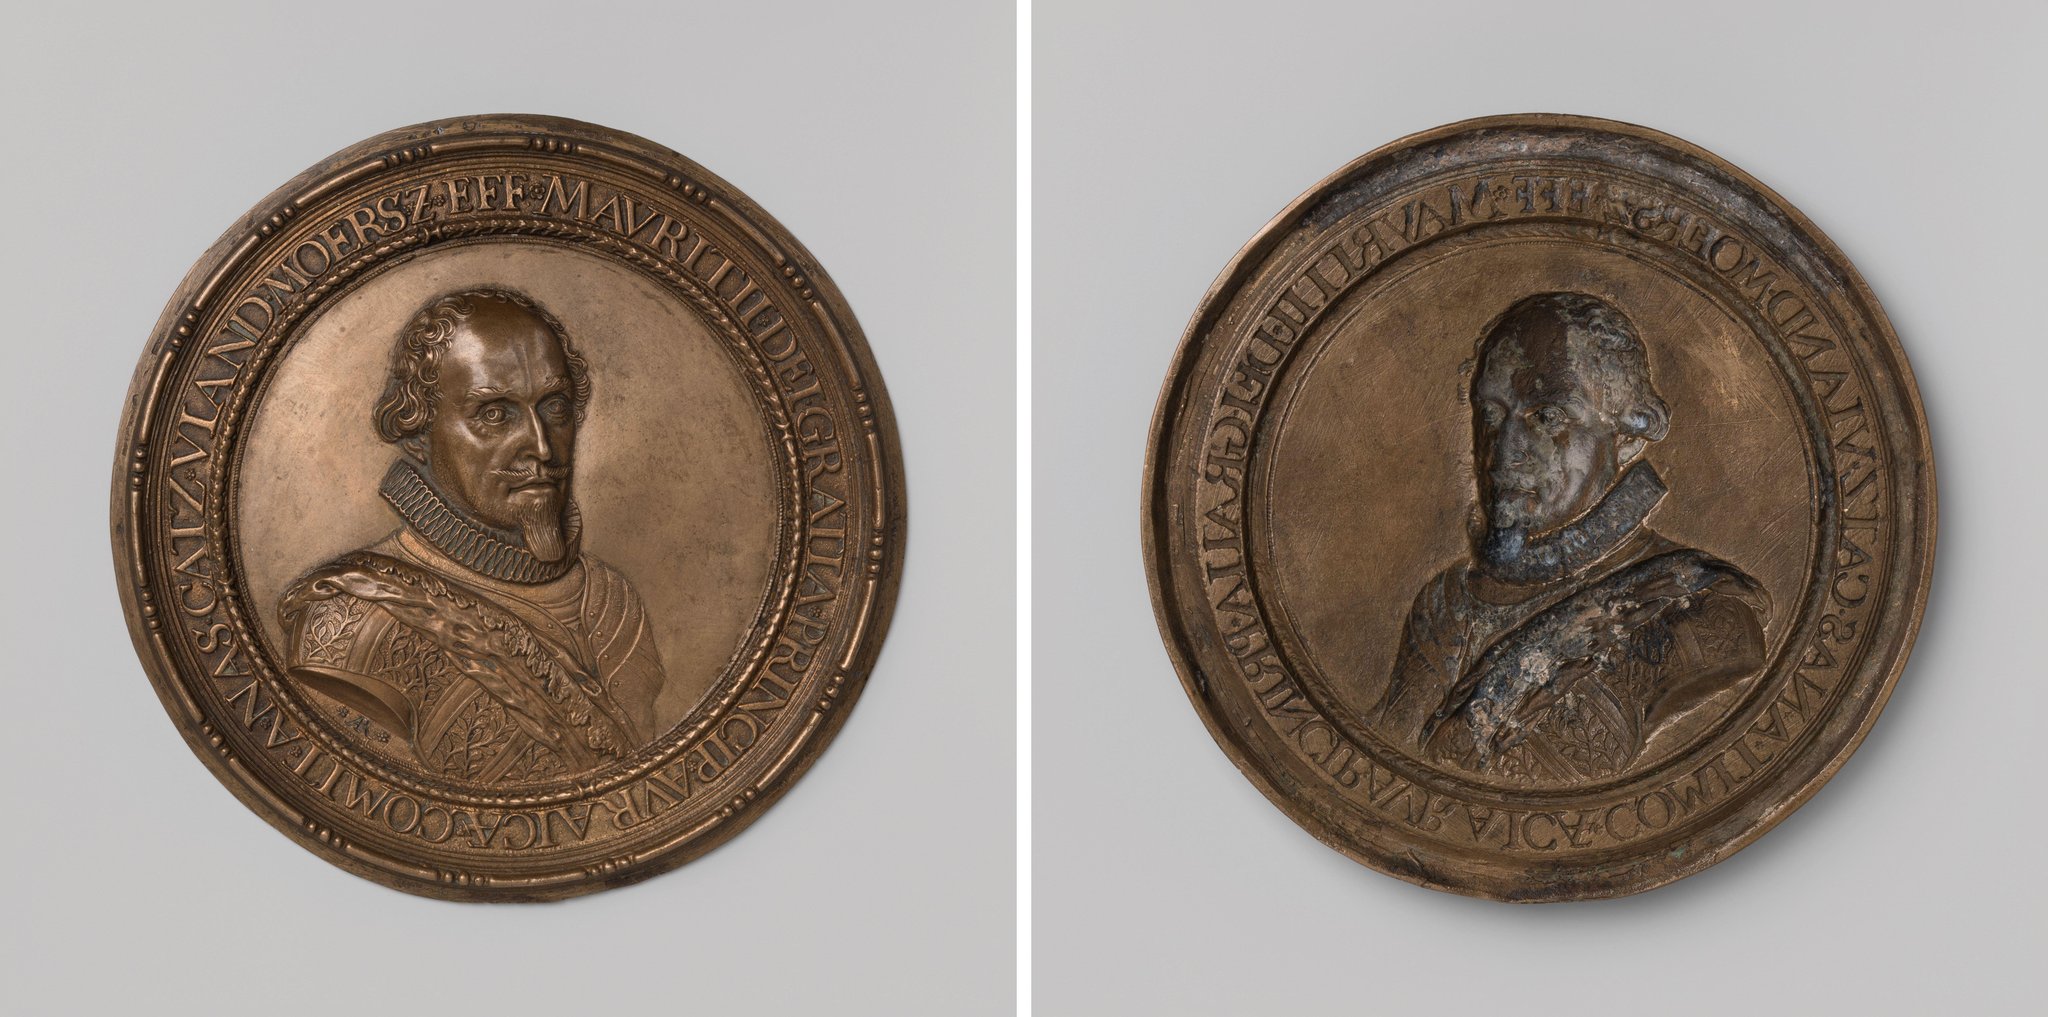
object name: plaque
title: Maurits, prins van Oranje-Nassau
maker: adriaen symonsz. rottermont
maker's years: 1579-1652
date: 1618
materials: brass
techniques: casting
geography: netherlands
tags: the hague, maurice (prince of orange), amsterdam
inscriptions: signature: ‘AR’, circumscription: ‘MAVRITII . DEI . GRATIA . PRINCIP . AVRAIGÆ . COMITA . NAS . CATZ . VIAND . MOERS . Z . E . FF .’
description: Eenzijdige plaquette. Voorzijde: borststuk man in harnas binnen omschrift en versierde rand. Gemerkt op rechterschouder. Keerzijde: blanco. Oorspronkelijk in zwart houten lijstje.